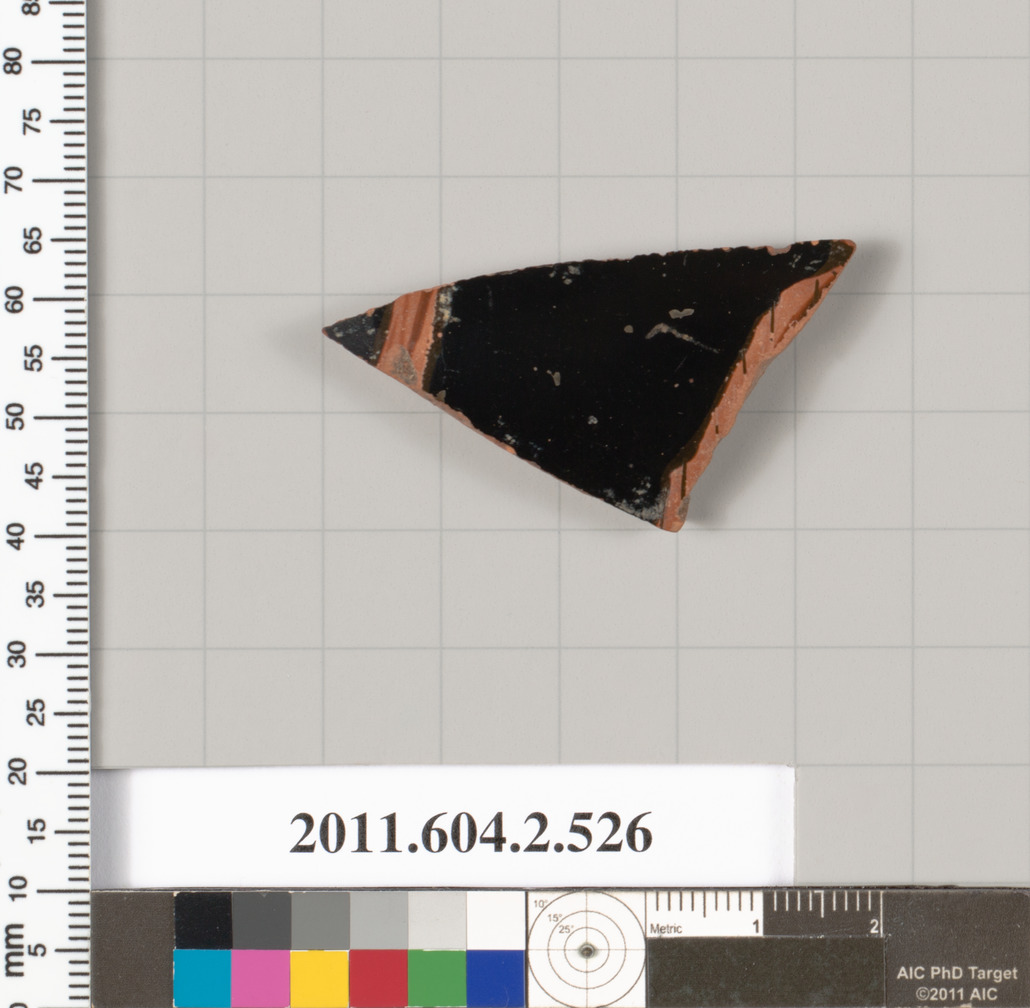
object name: column krater fragment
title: Terracotta fragment of a column-krater (bowl for mixing wine and water)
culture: greek, attic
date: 460-440 BCE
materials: terracotta